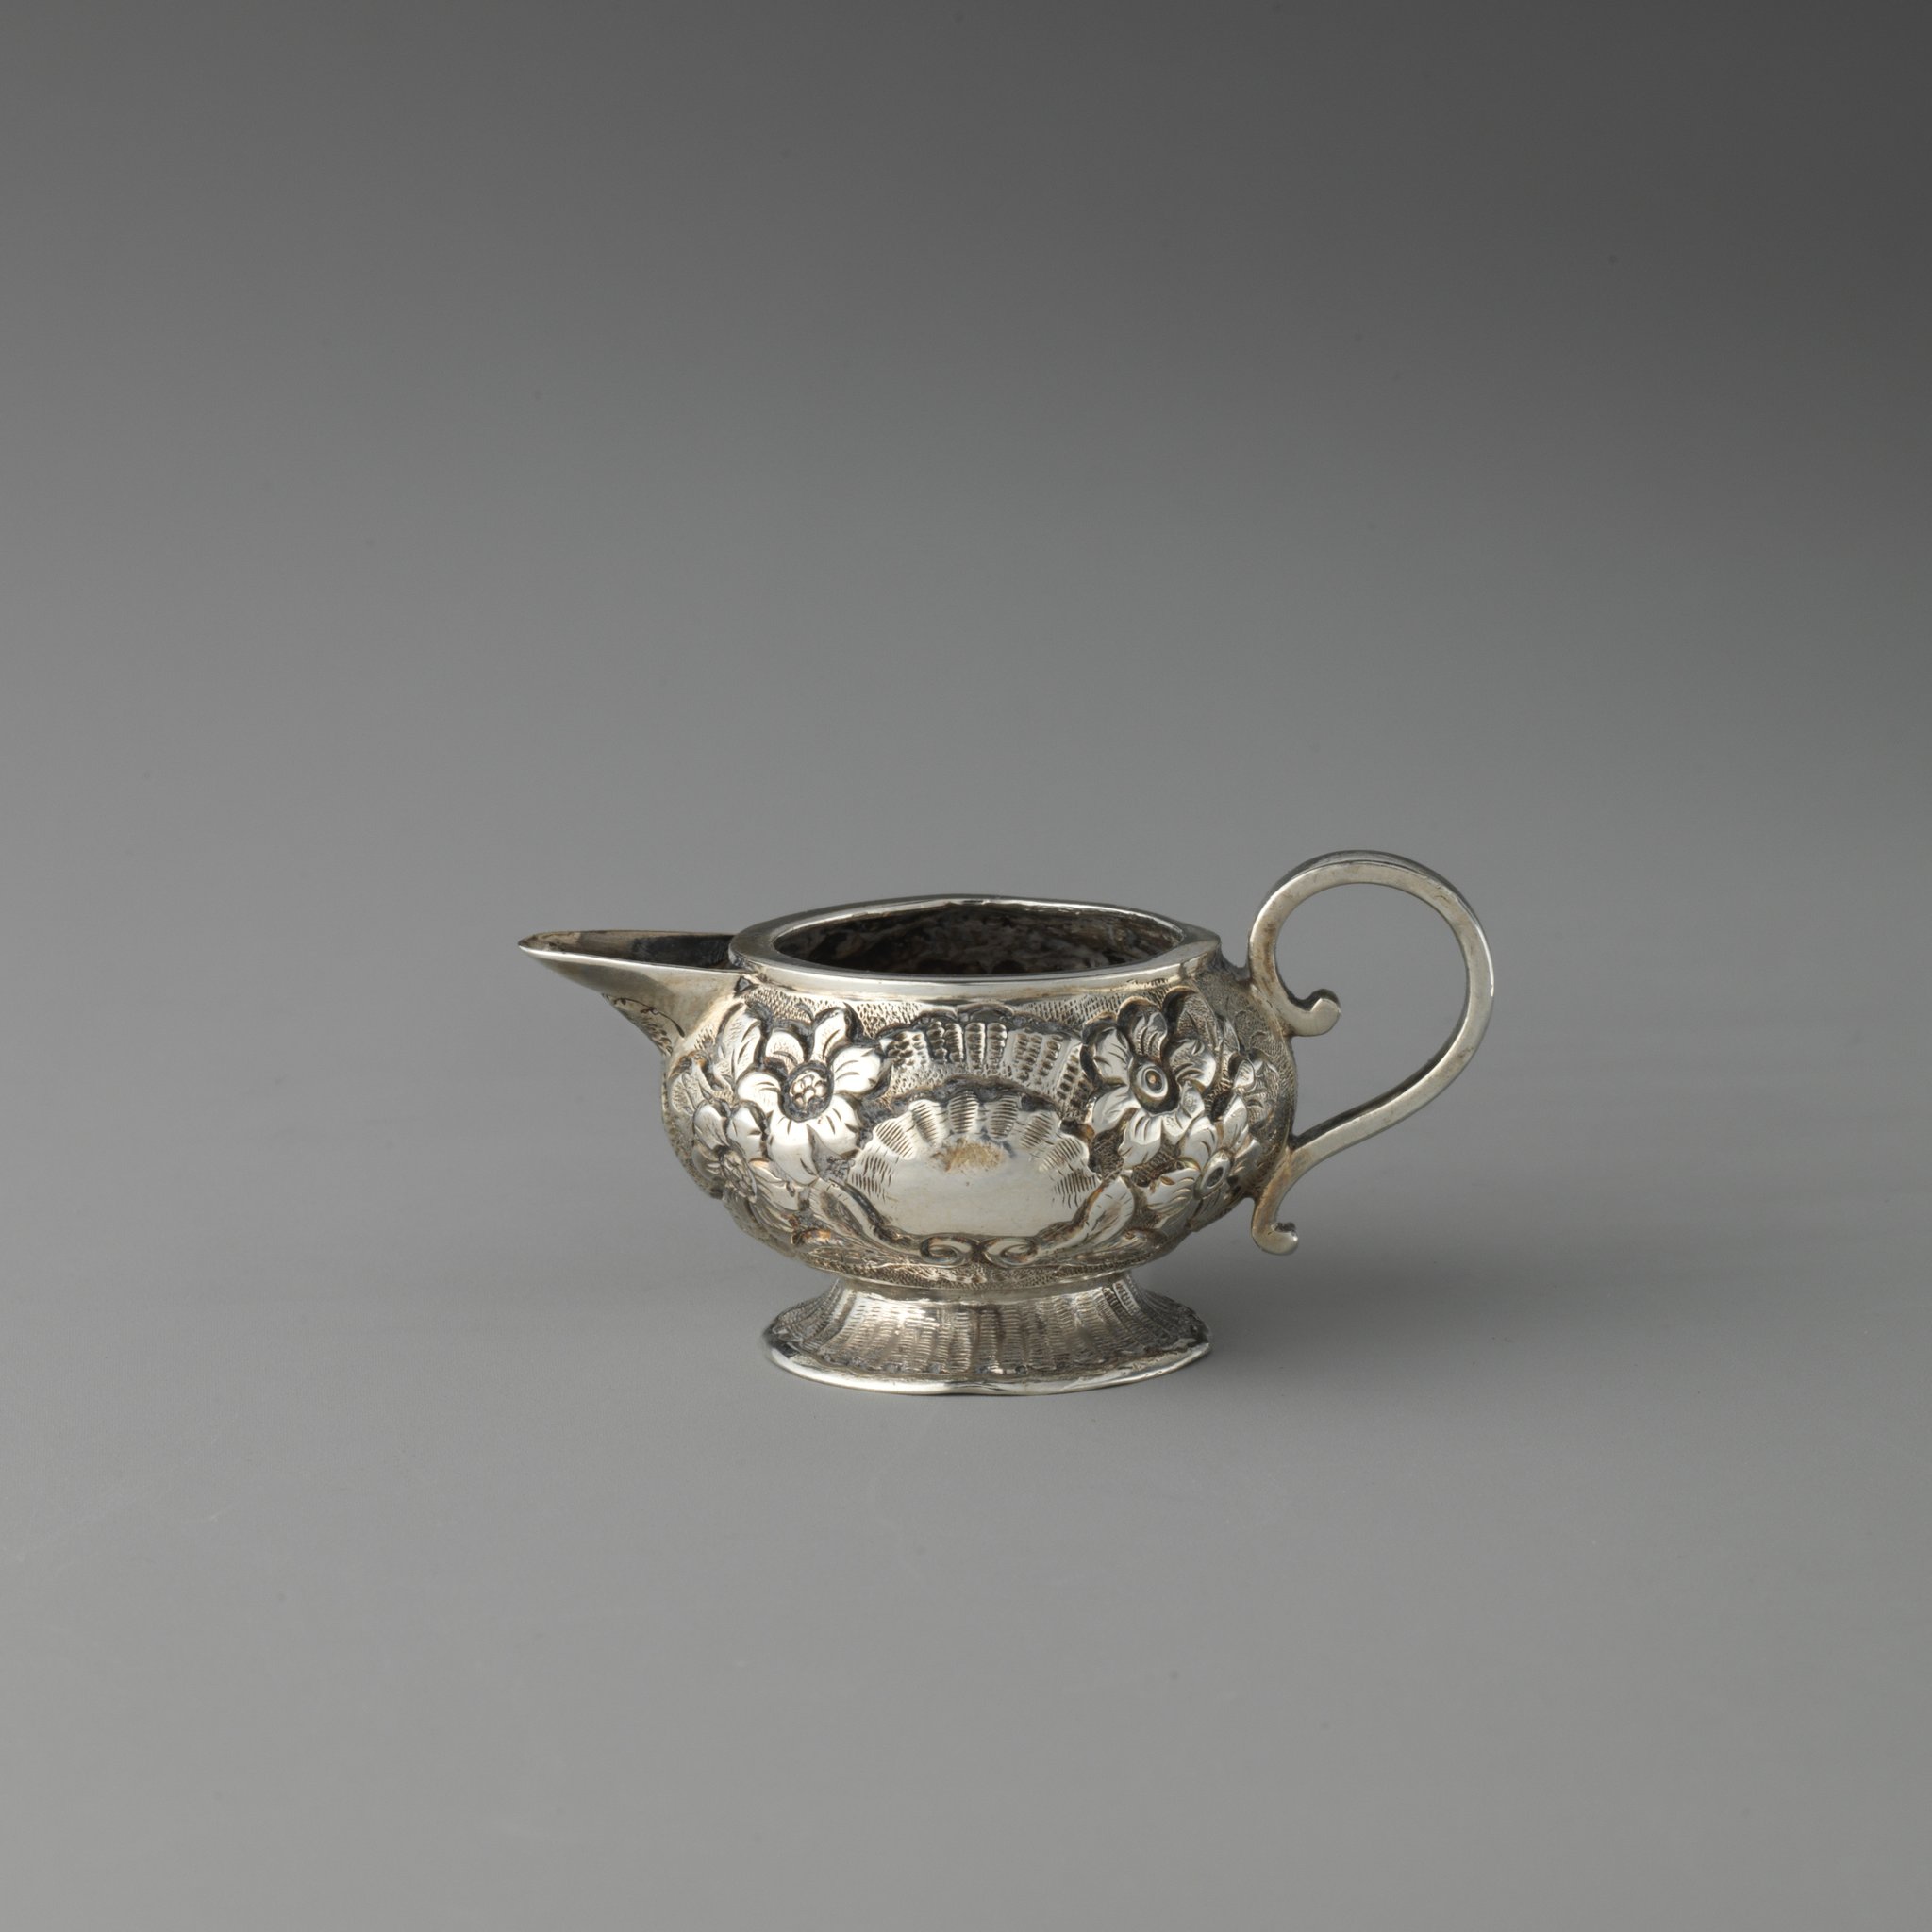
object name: creamer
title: Miniature creamer (part of a set)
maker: henry flavelle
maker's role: artist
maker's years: 1750-1850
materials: silver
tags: flowers